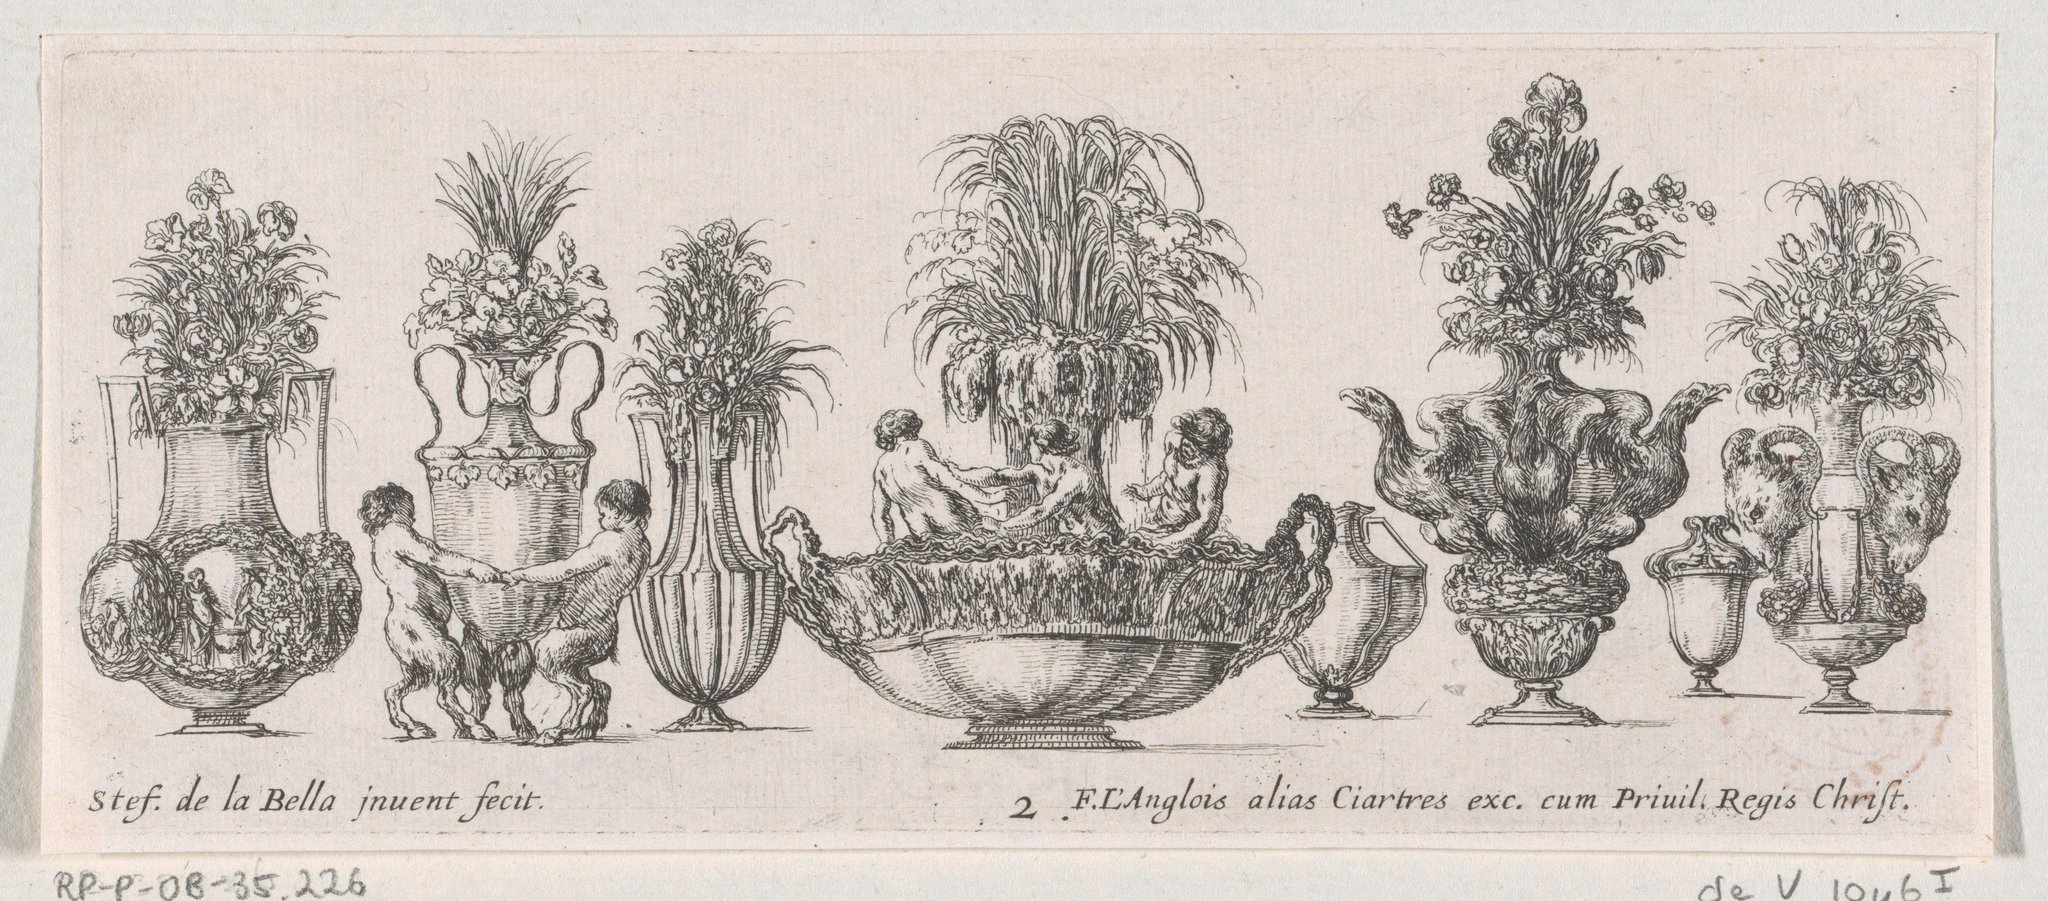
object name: print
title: Acht vazen op een rij, de middelste met twee nimfen en een triton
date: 1620-1664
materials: paper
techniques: etching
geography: france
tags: vase ~ ornament, garden vase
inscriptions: collector's mark: Lugt 240